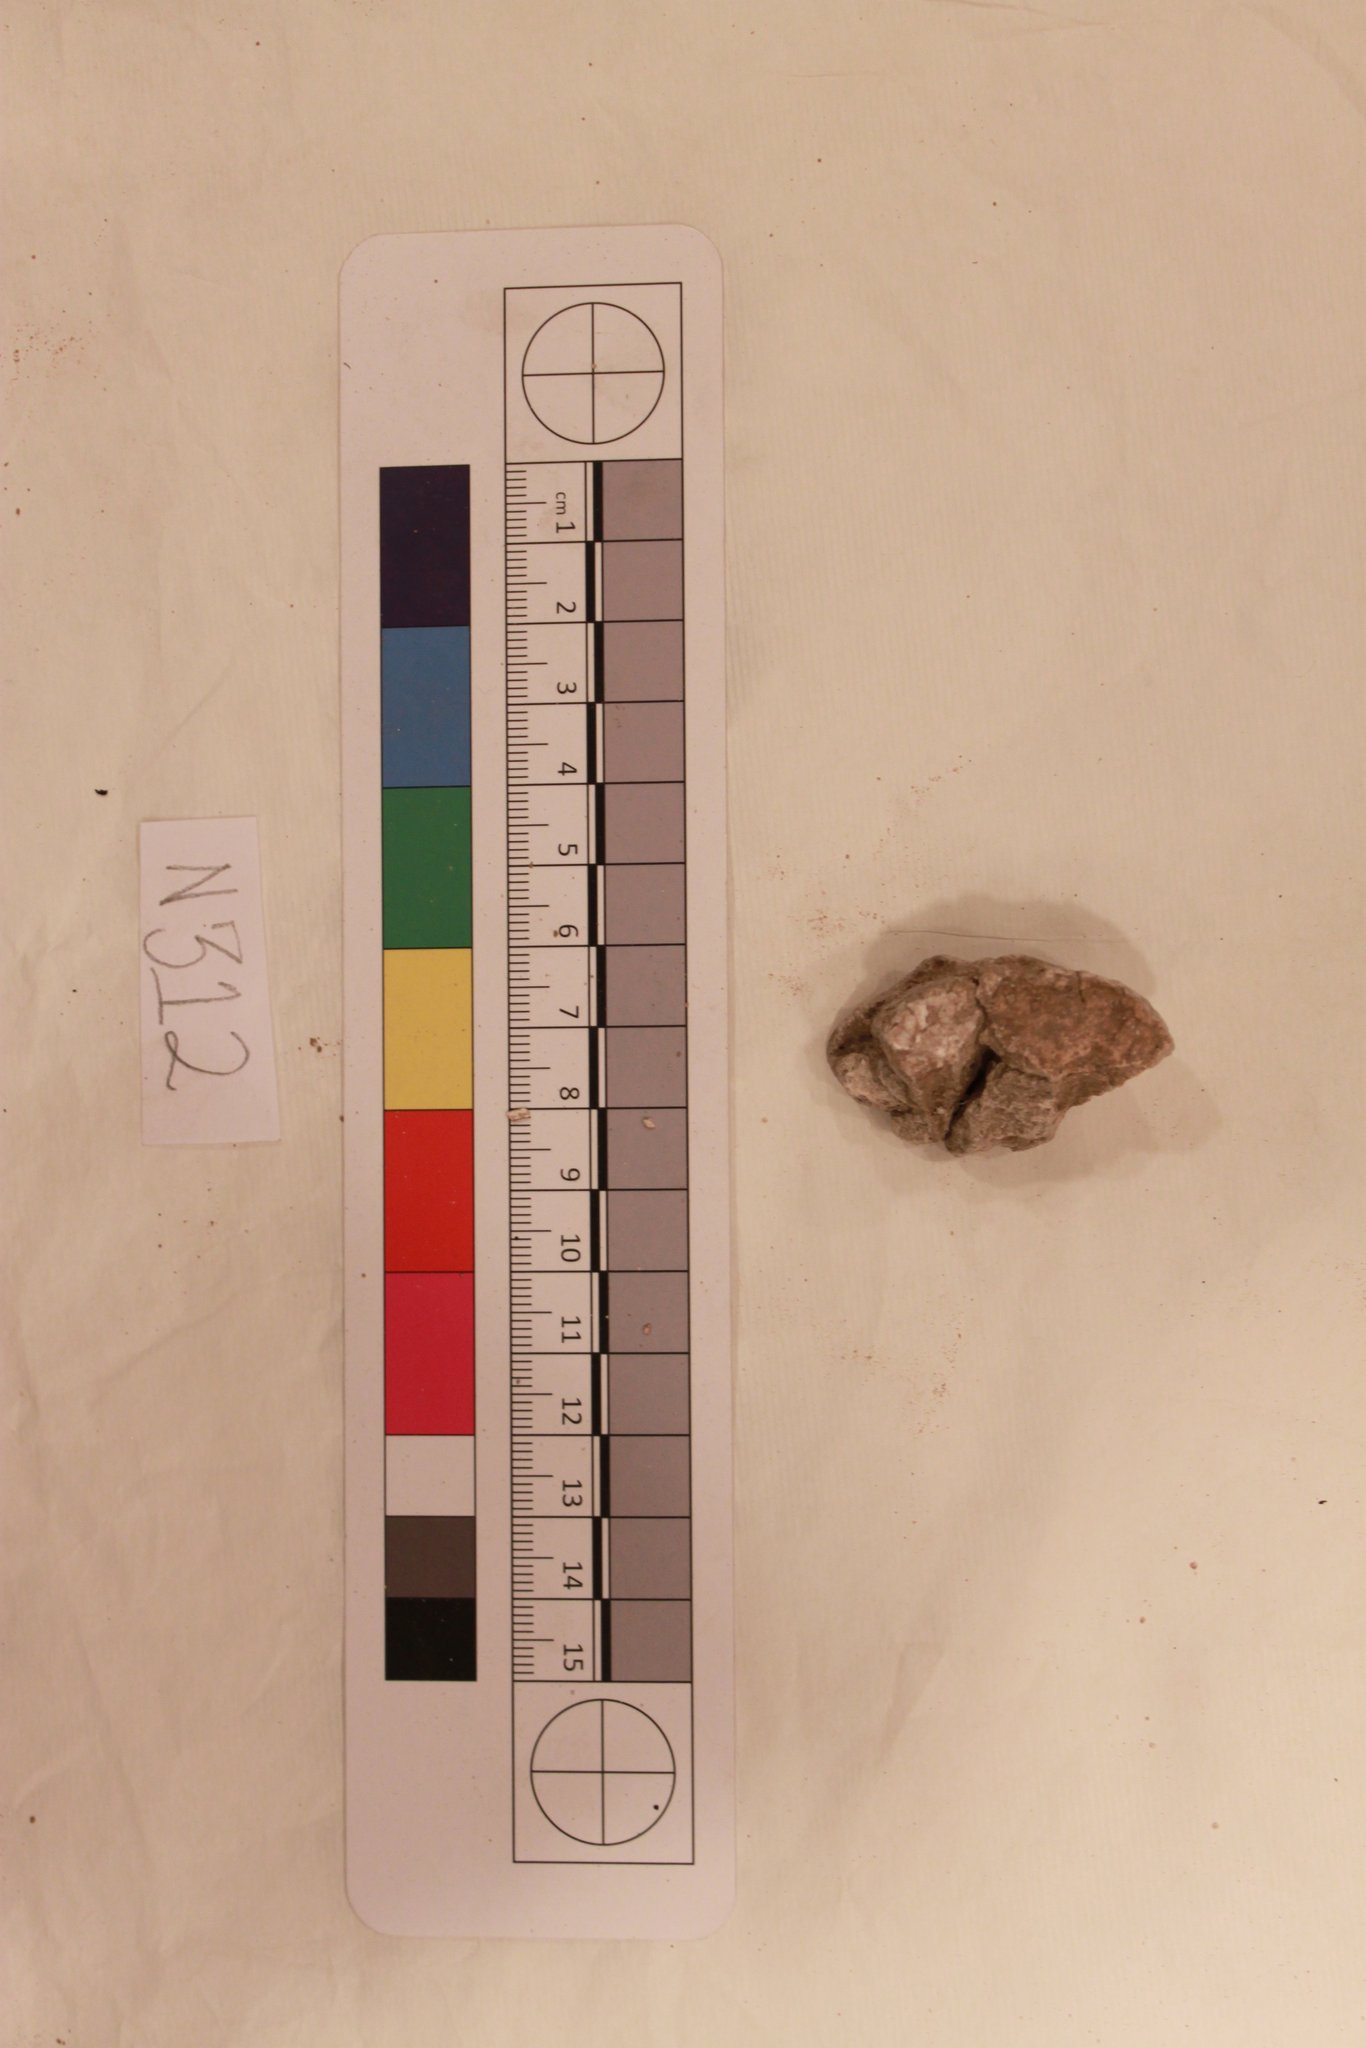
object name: fragment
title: Stucco Fragment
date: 701-1200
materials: plaster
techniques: carving, painting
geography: iran